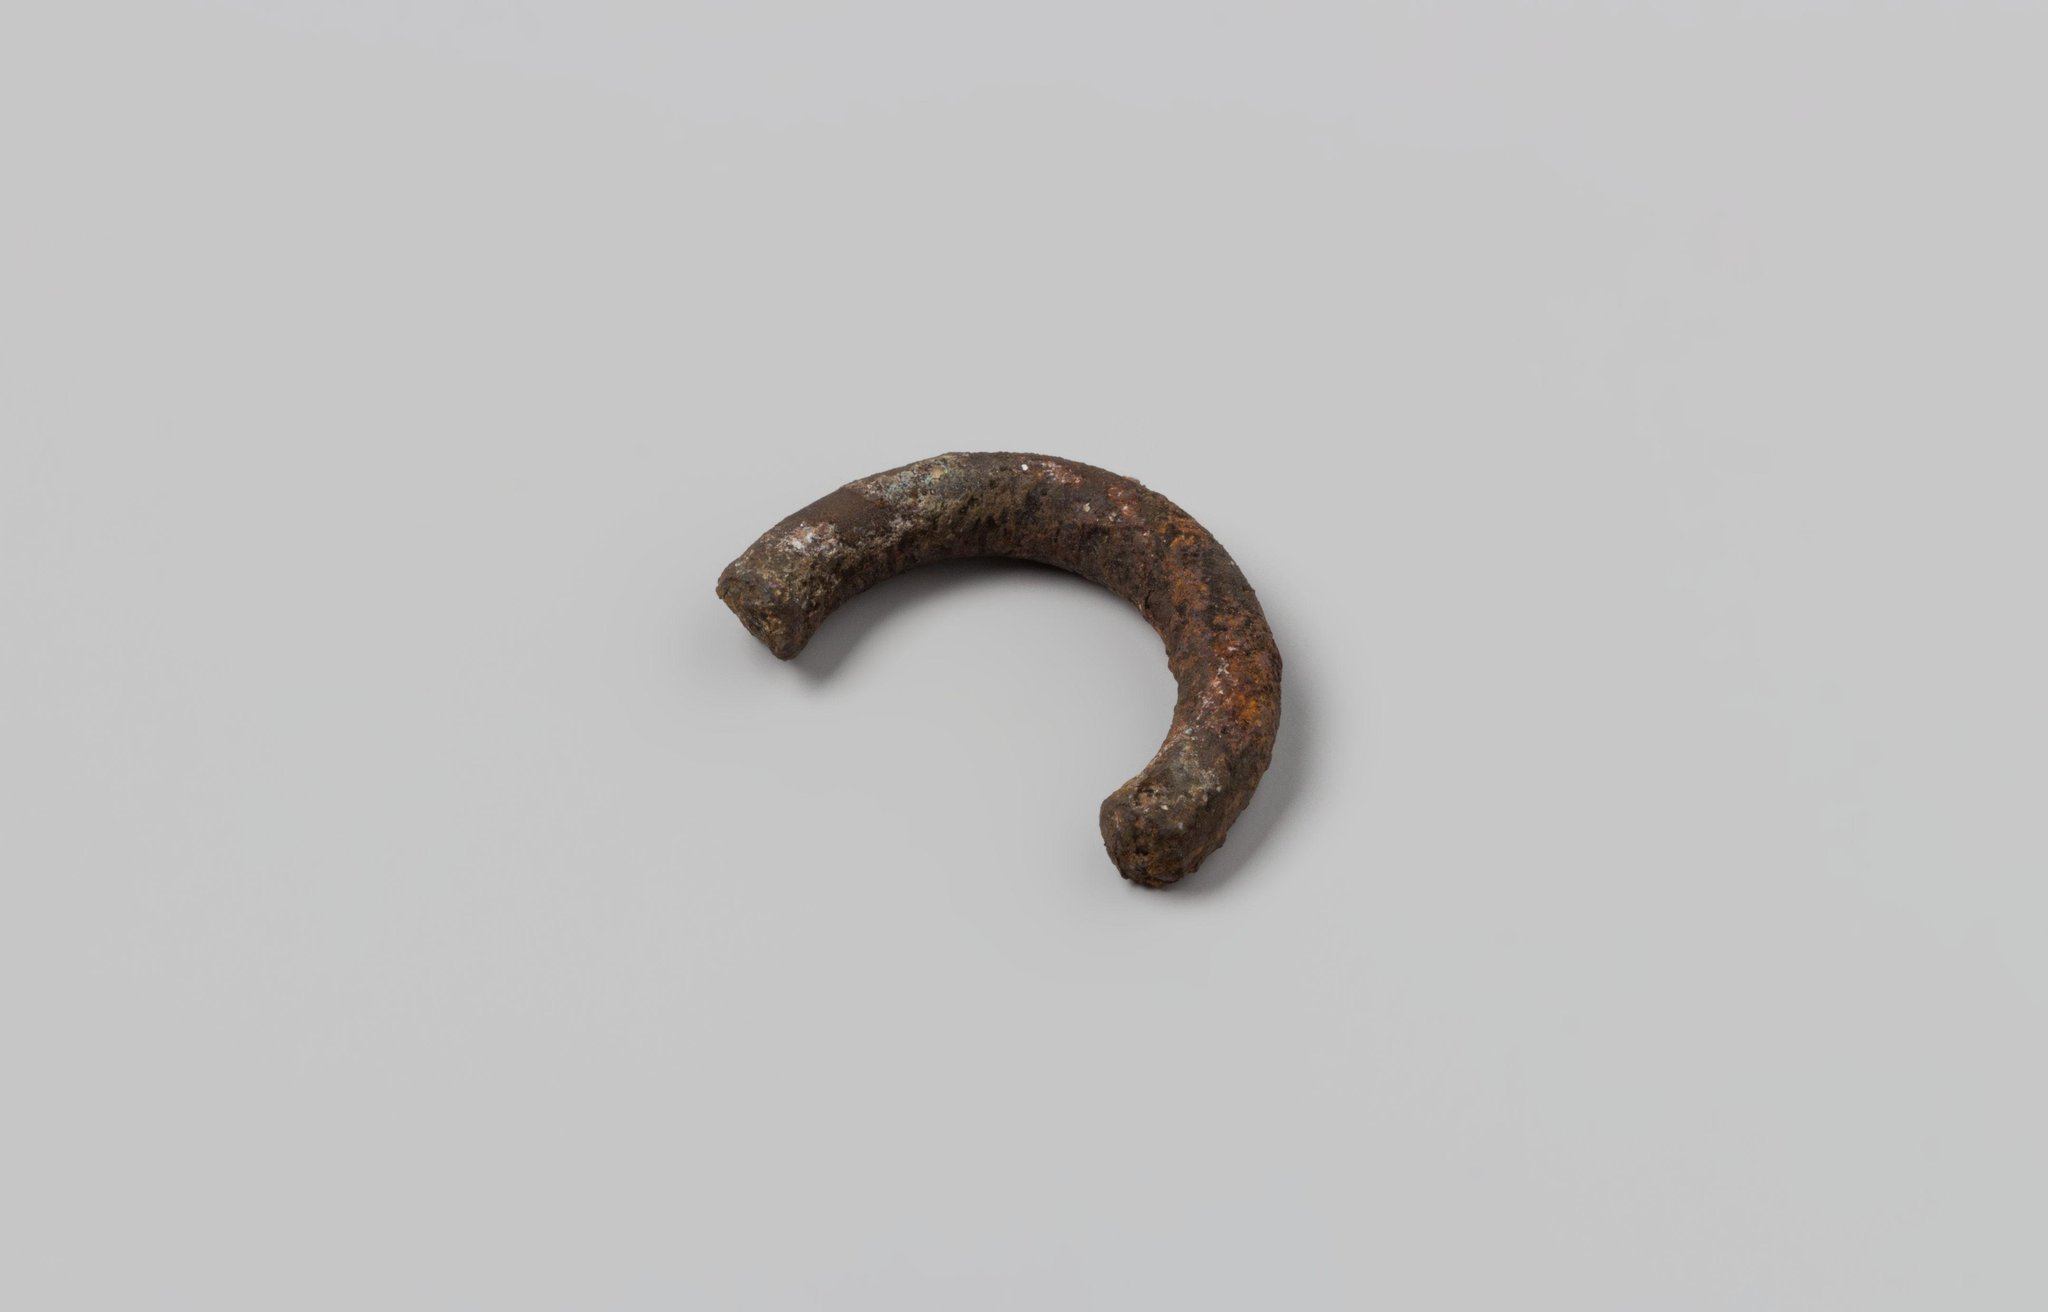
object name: spigot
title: Fragment tapkraan uit het wrak van de Oost-Indiëvaarder Hollandia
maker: Anonymous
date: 1700-1743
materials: copper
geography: netherlands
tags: verenigde oostindische compagnie, hollandia (schip), annet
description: Tap, spigot, removable; fragm of ring-shaped handle, sim. NG 1980-27H903.